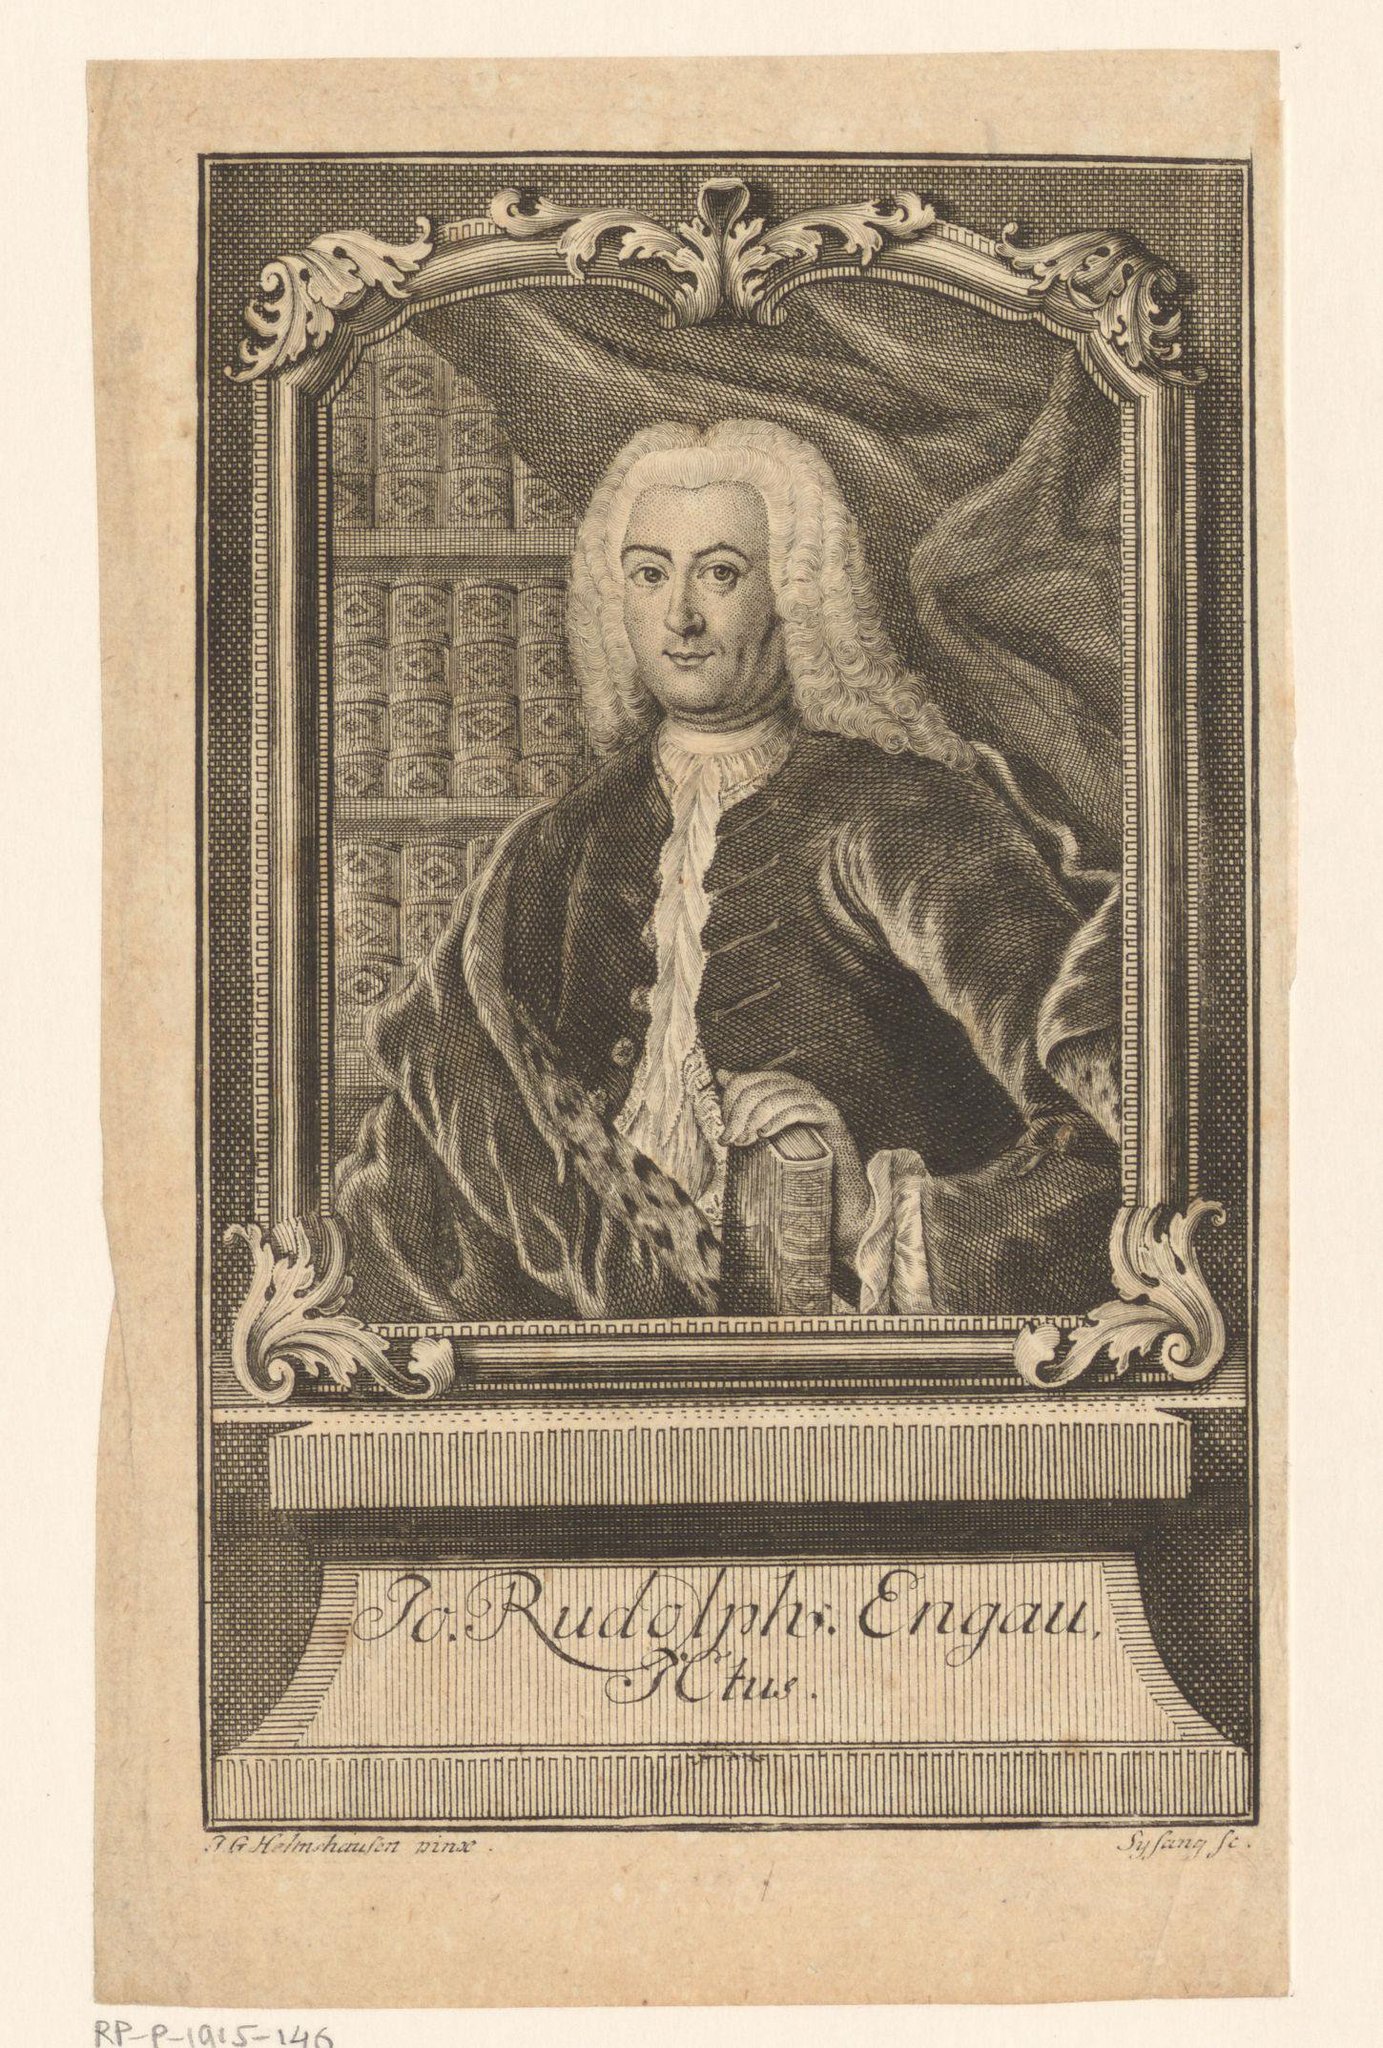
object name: print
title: Portret van Johann Rudolf Engau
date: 1738-1757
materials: paper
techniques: engraving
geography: germany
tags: bookshelves, historical persons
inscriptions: collector's mark: Lugt 2228